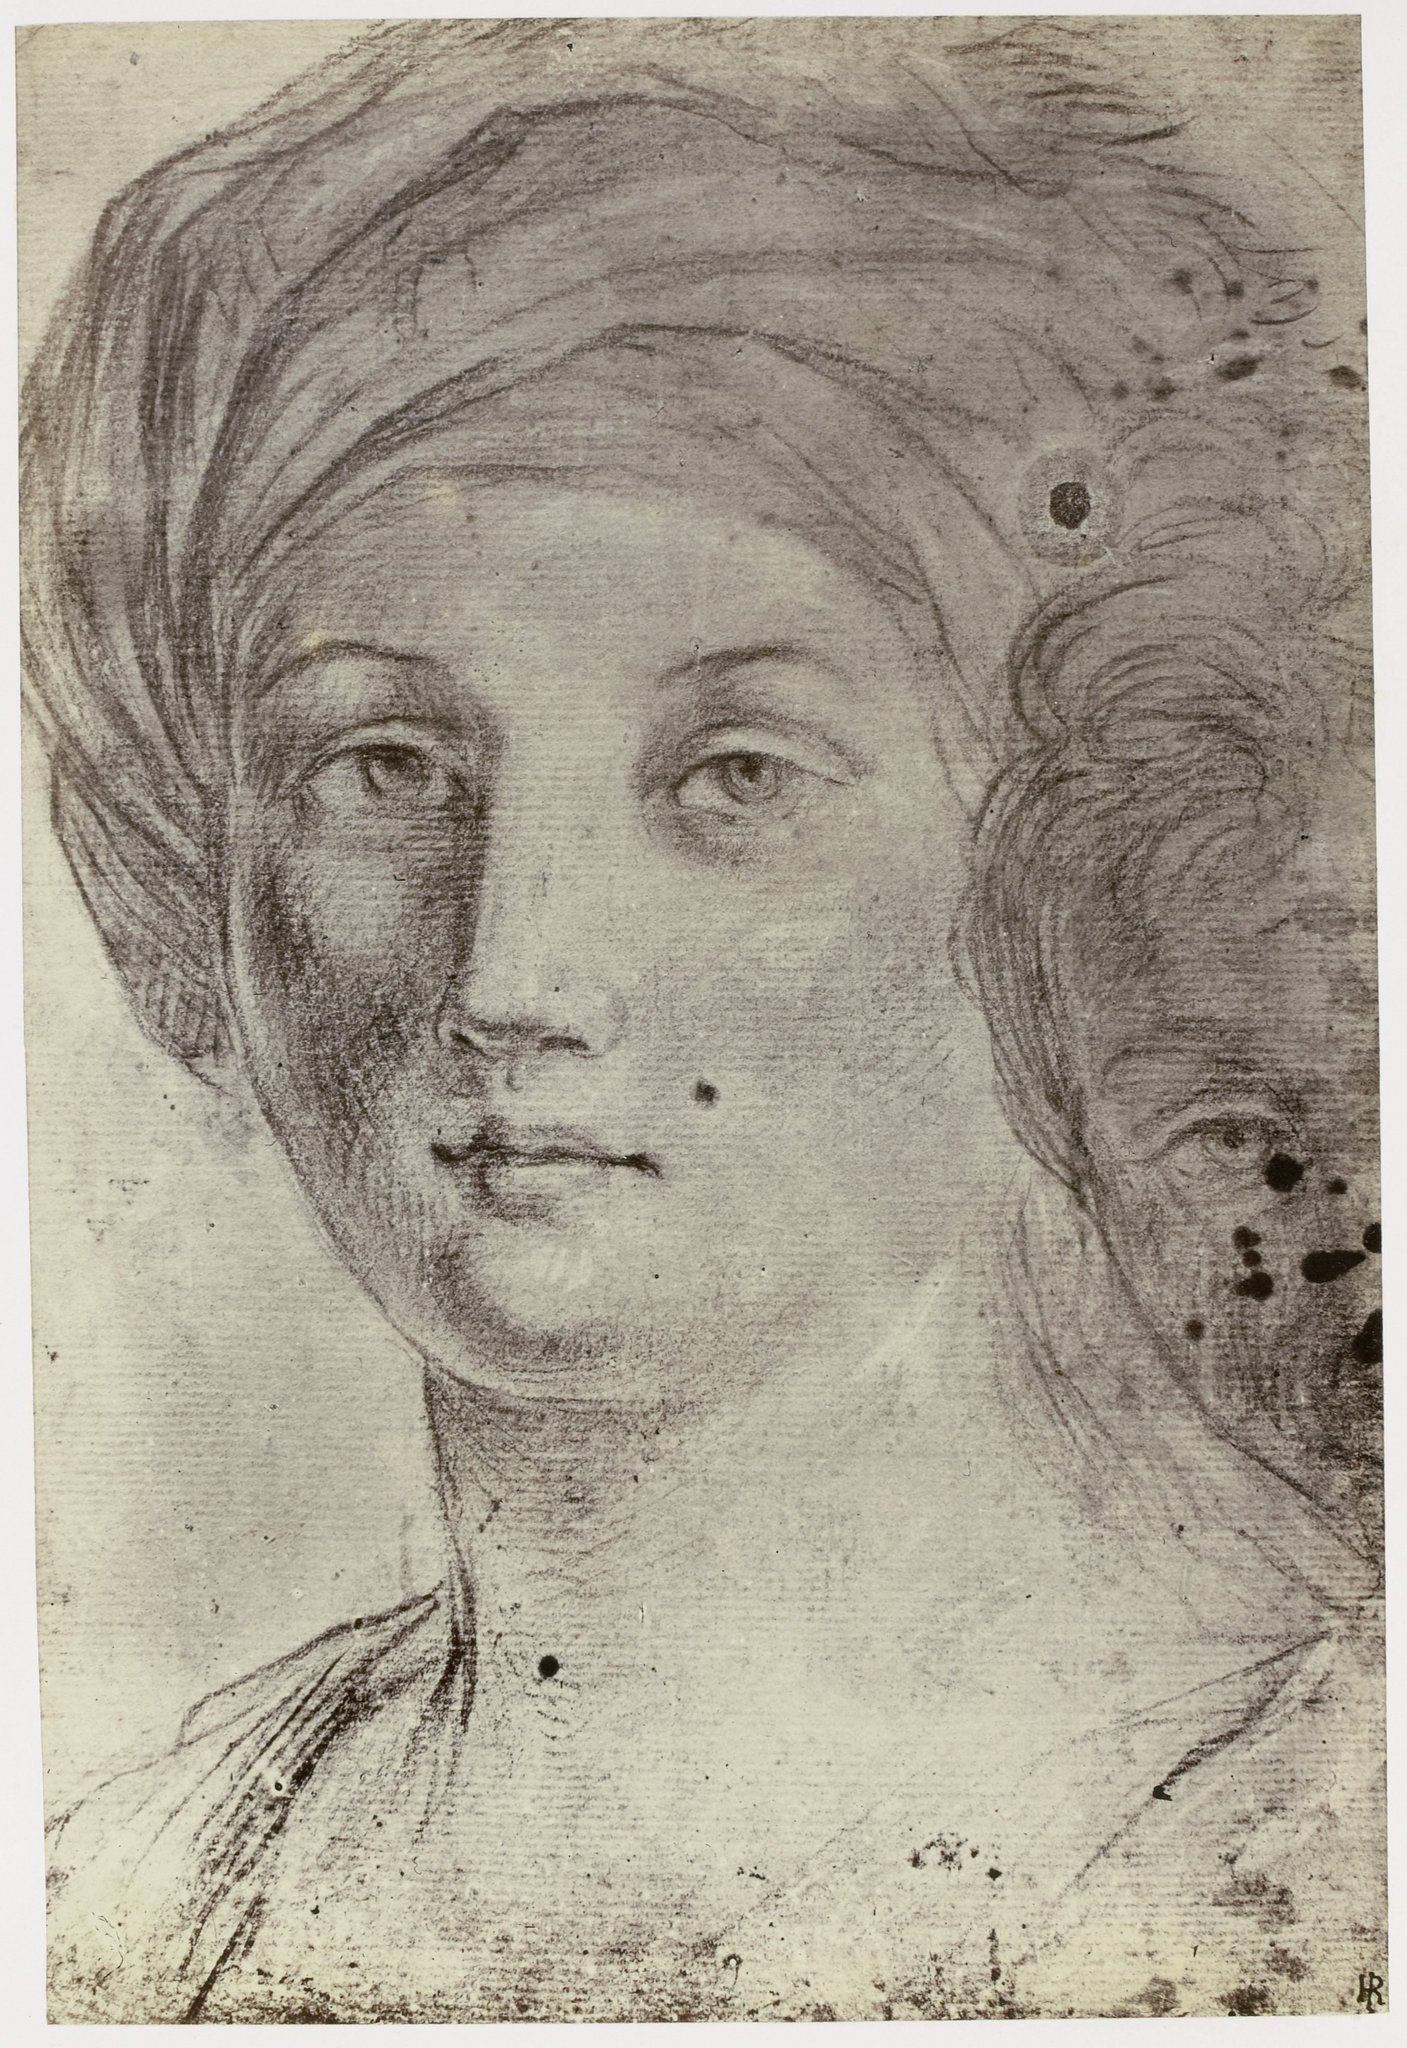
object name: photograph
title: Guido, His Wife's Portrait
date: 1855-1858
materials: cardboard, paper, photographic support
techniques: albumen print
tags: drawing, sketch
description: Fotoreproductie van tekening in 'The Reveley Collection of Drawings at Brynygwin', afb. 5.